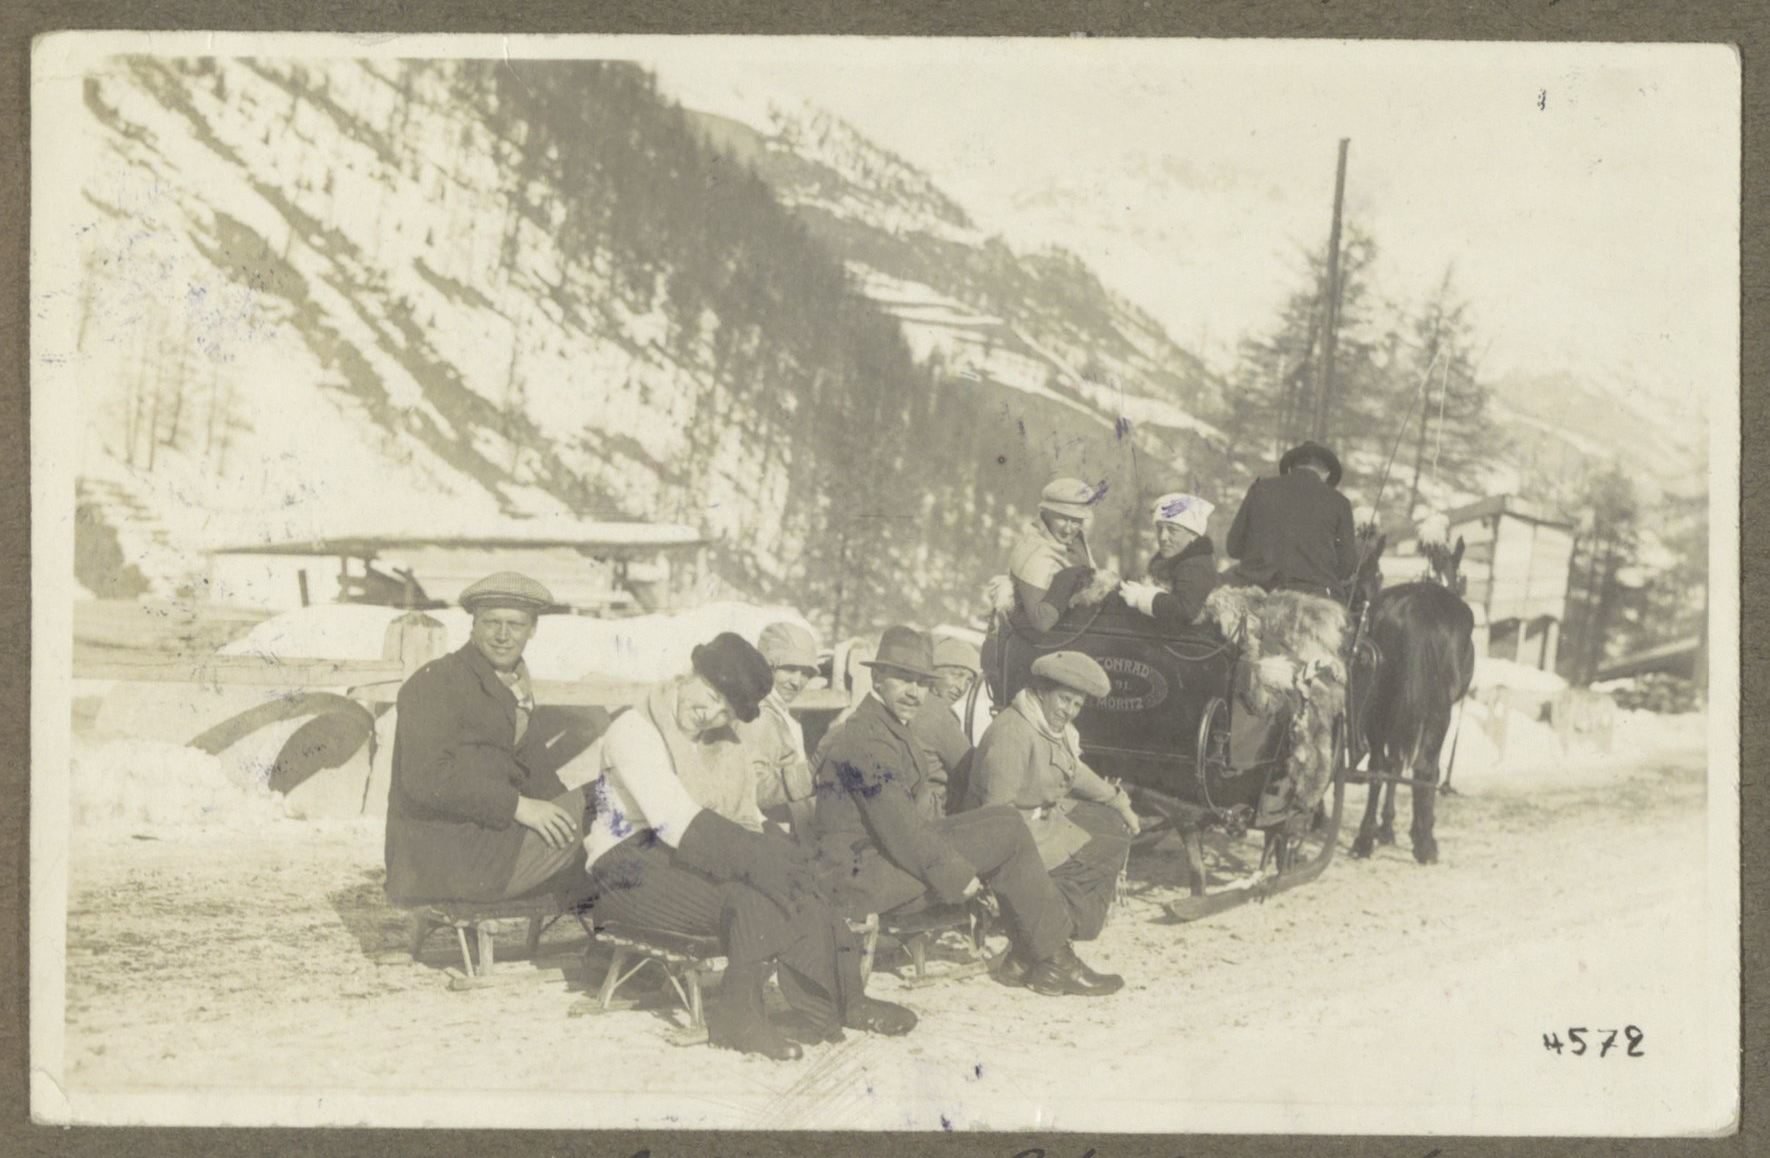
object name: photograph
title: Gezelschap waaronder leden van de familie Ottenhof achter een paardenslee in Sankt Moritz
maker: Anonymous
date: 1921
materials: photographic support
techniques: gelatin silver print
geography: sankt moritz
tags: horse-sleigh, small sleigh (winter sports)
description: Onderdeel van fotoalbum van een onbekende Nederlandse familie met opnames van Suriname, Europa en Nederlands-Indië.